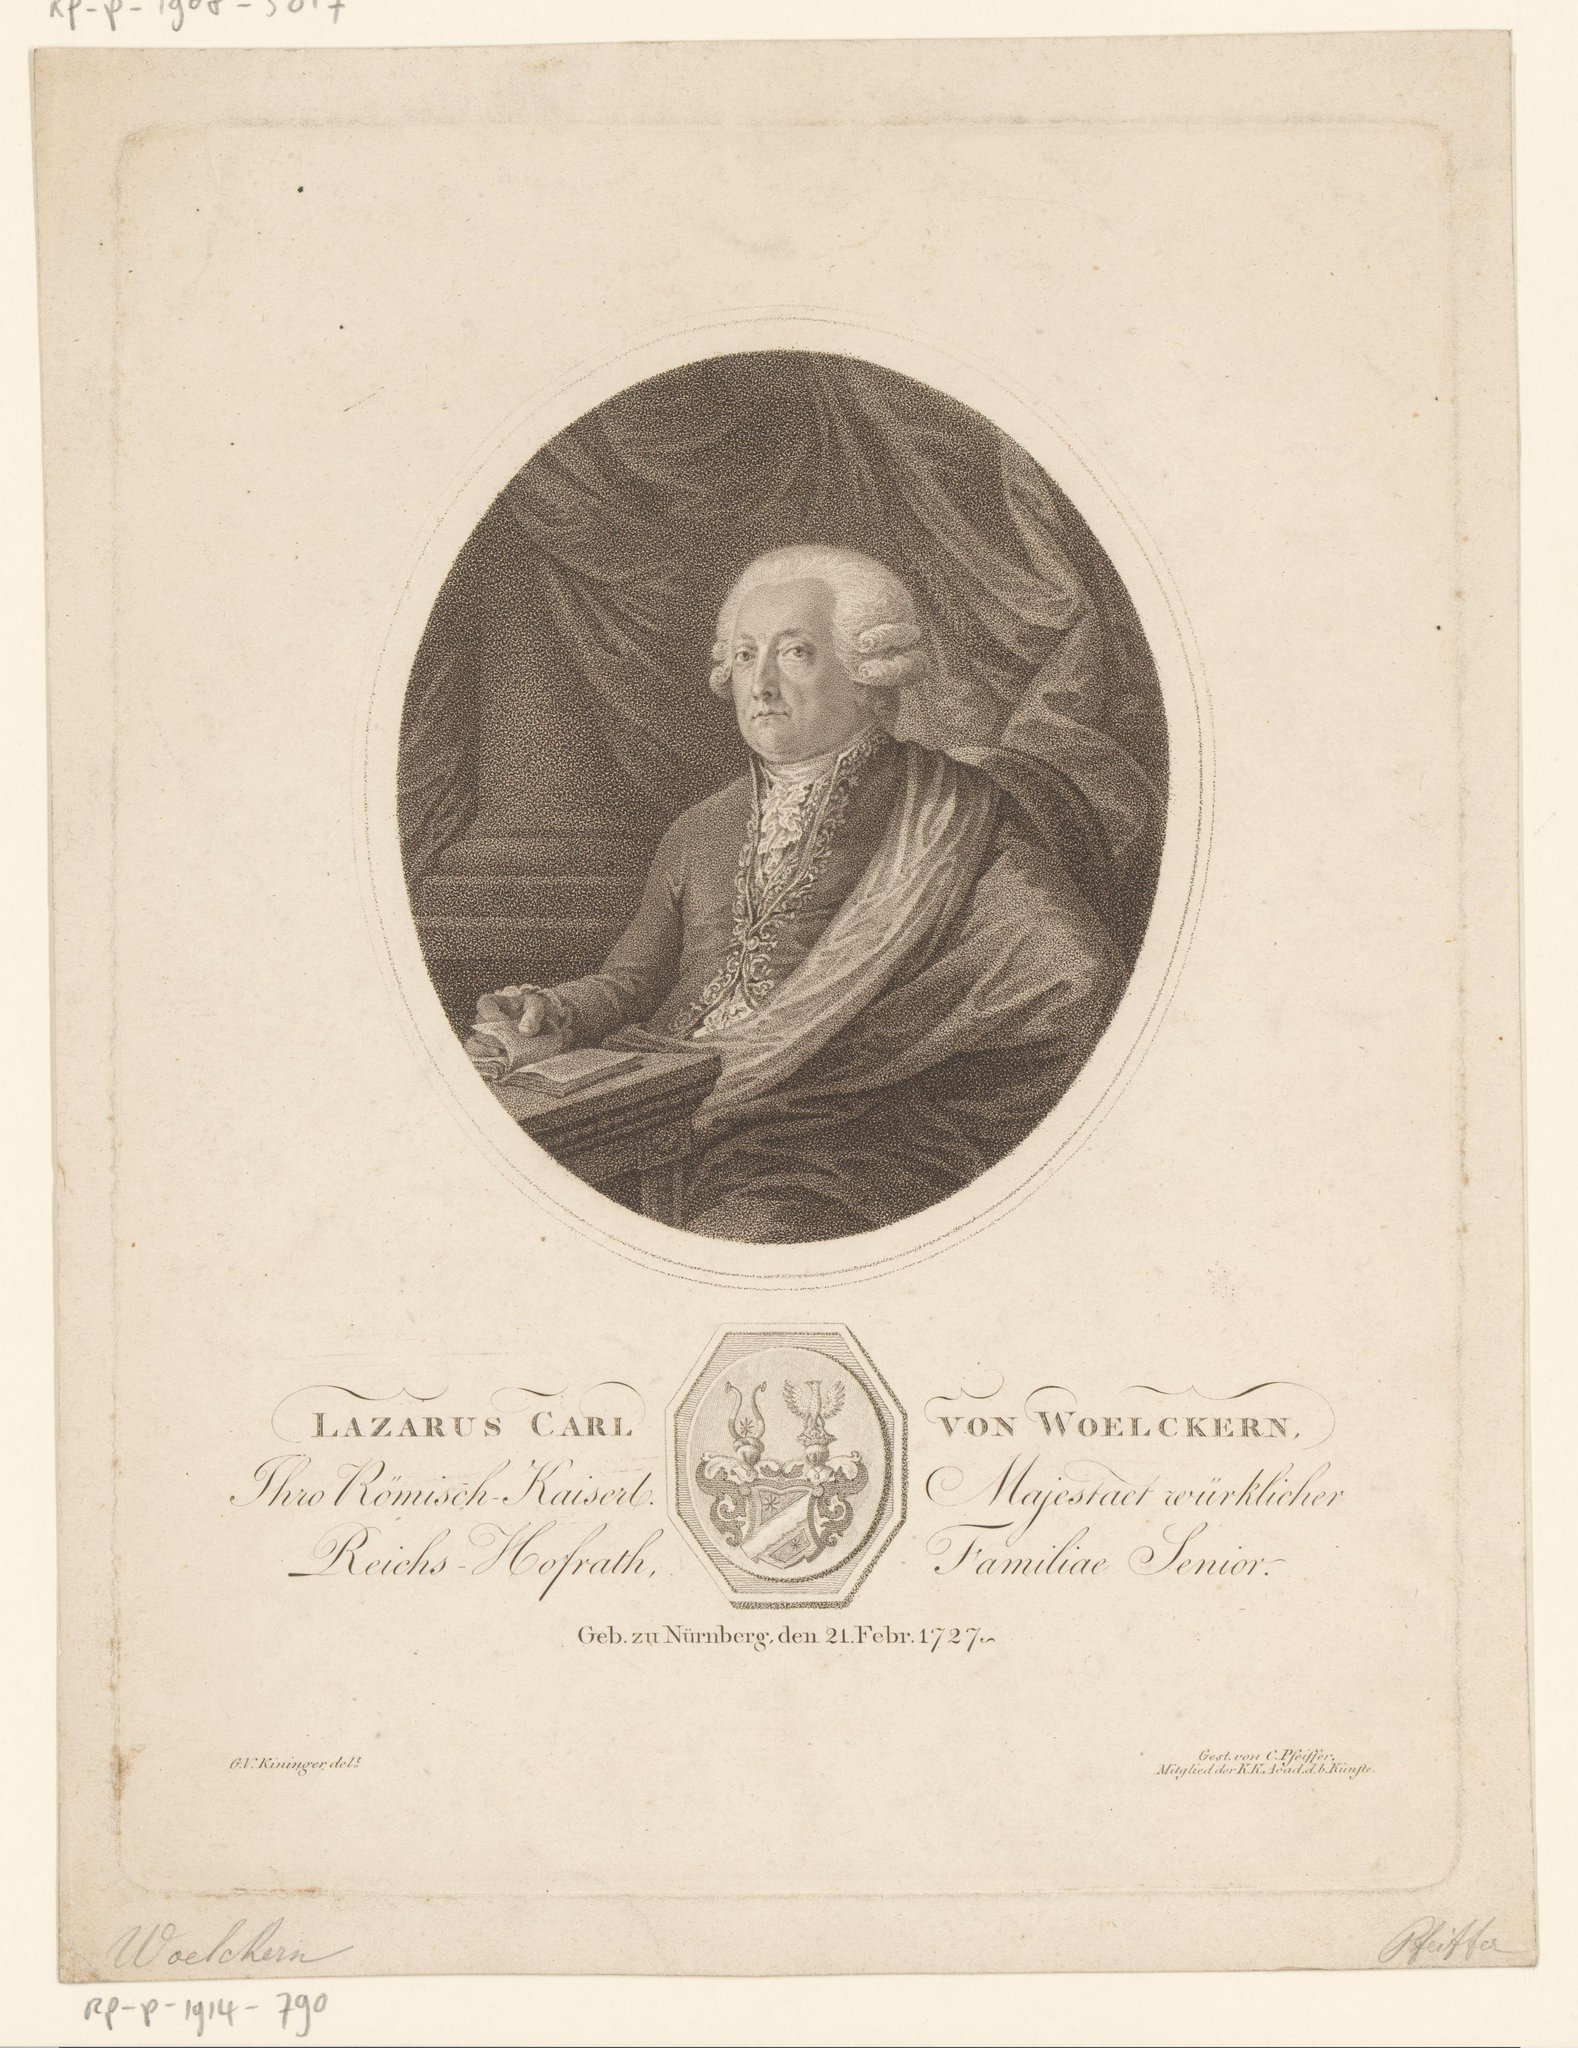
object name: print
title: Portret van Lazarus Karl von Wölckern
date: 1779-1829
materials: paper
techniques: engraving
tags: historical persons, book, armorial bearing, heraldry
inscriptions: name, name, collector's mark: Lugt 2228